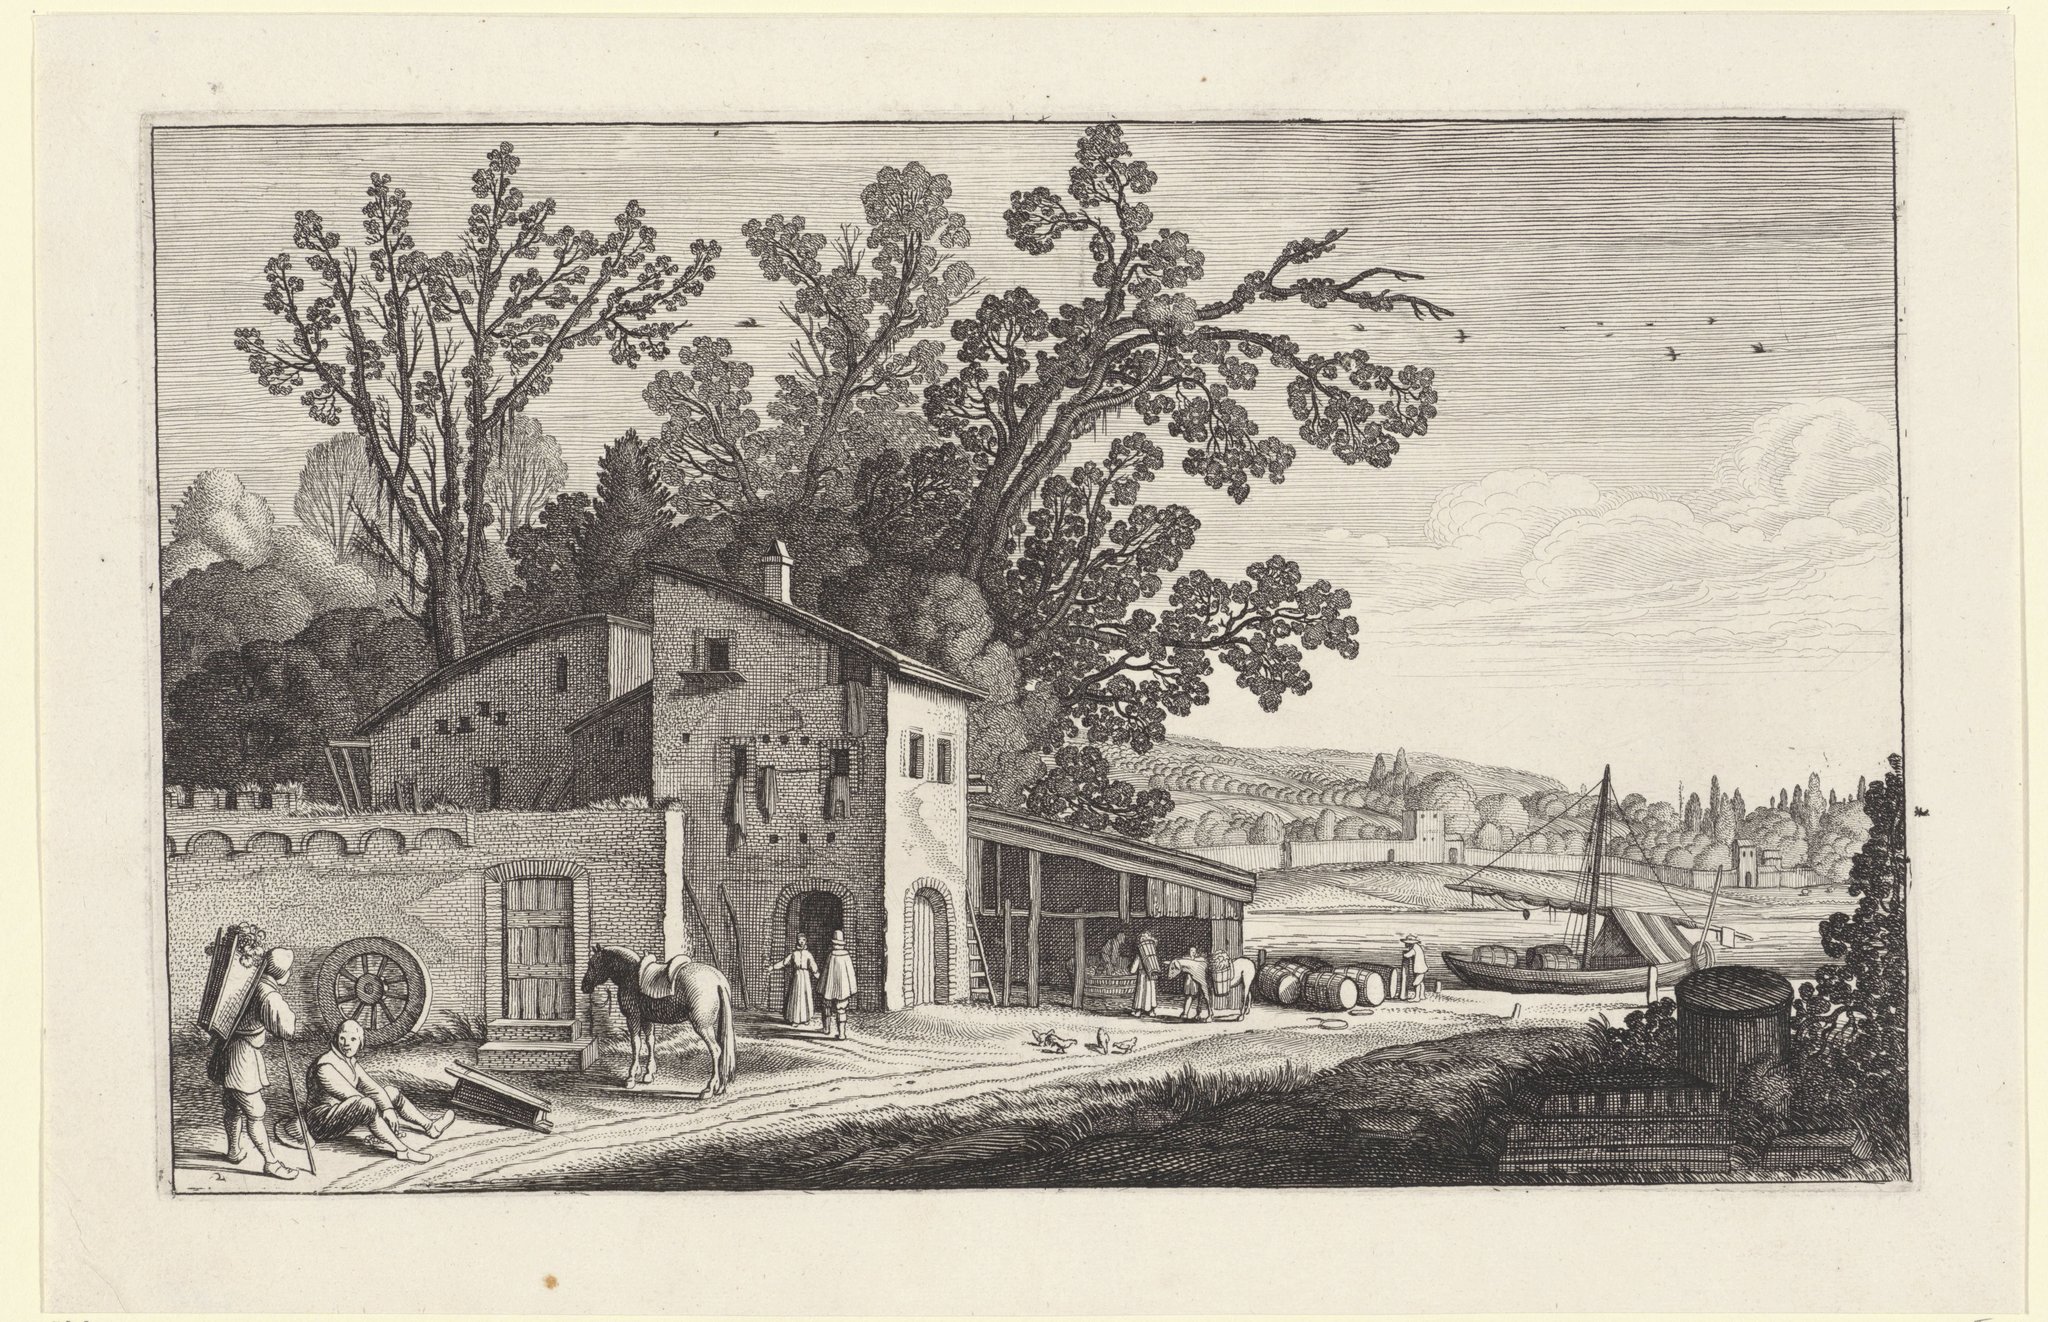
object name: print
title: Landschappen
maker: jan van de velde (ii)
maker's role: draughtsman, painter, print maker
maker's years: 1593-1641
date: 1603-1641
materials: paper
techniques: etching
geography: northern netherlands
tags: wooden container: barrel, cask, bucket, river, wine production, wine-press, traffic and transport (+ arrival, coming to anchor, at anchor)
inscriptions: collector's mark: Lugt 240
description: Wijnmakerij in een landschap. Op de achtergrond een rivier en heuvels. Tweede prent van een serie van vier.